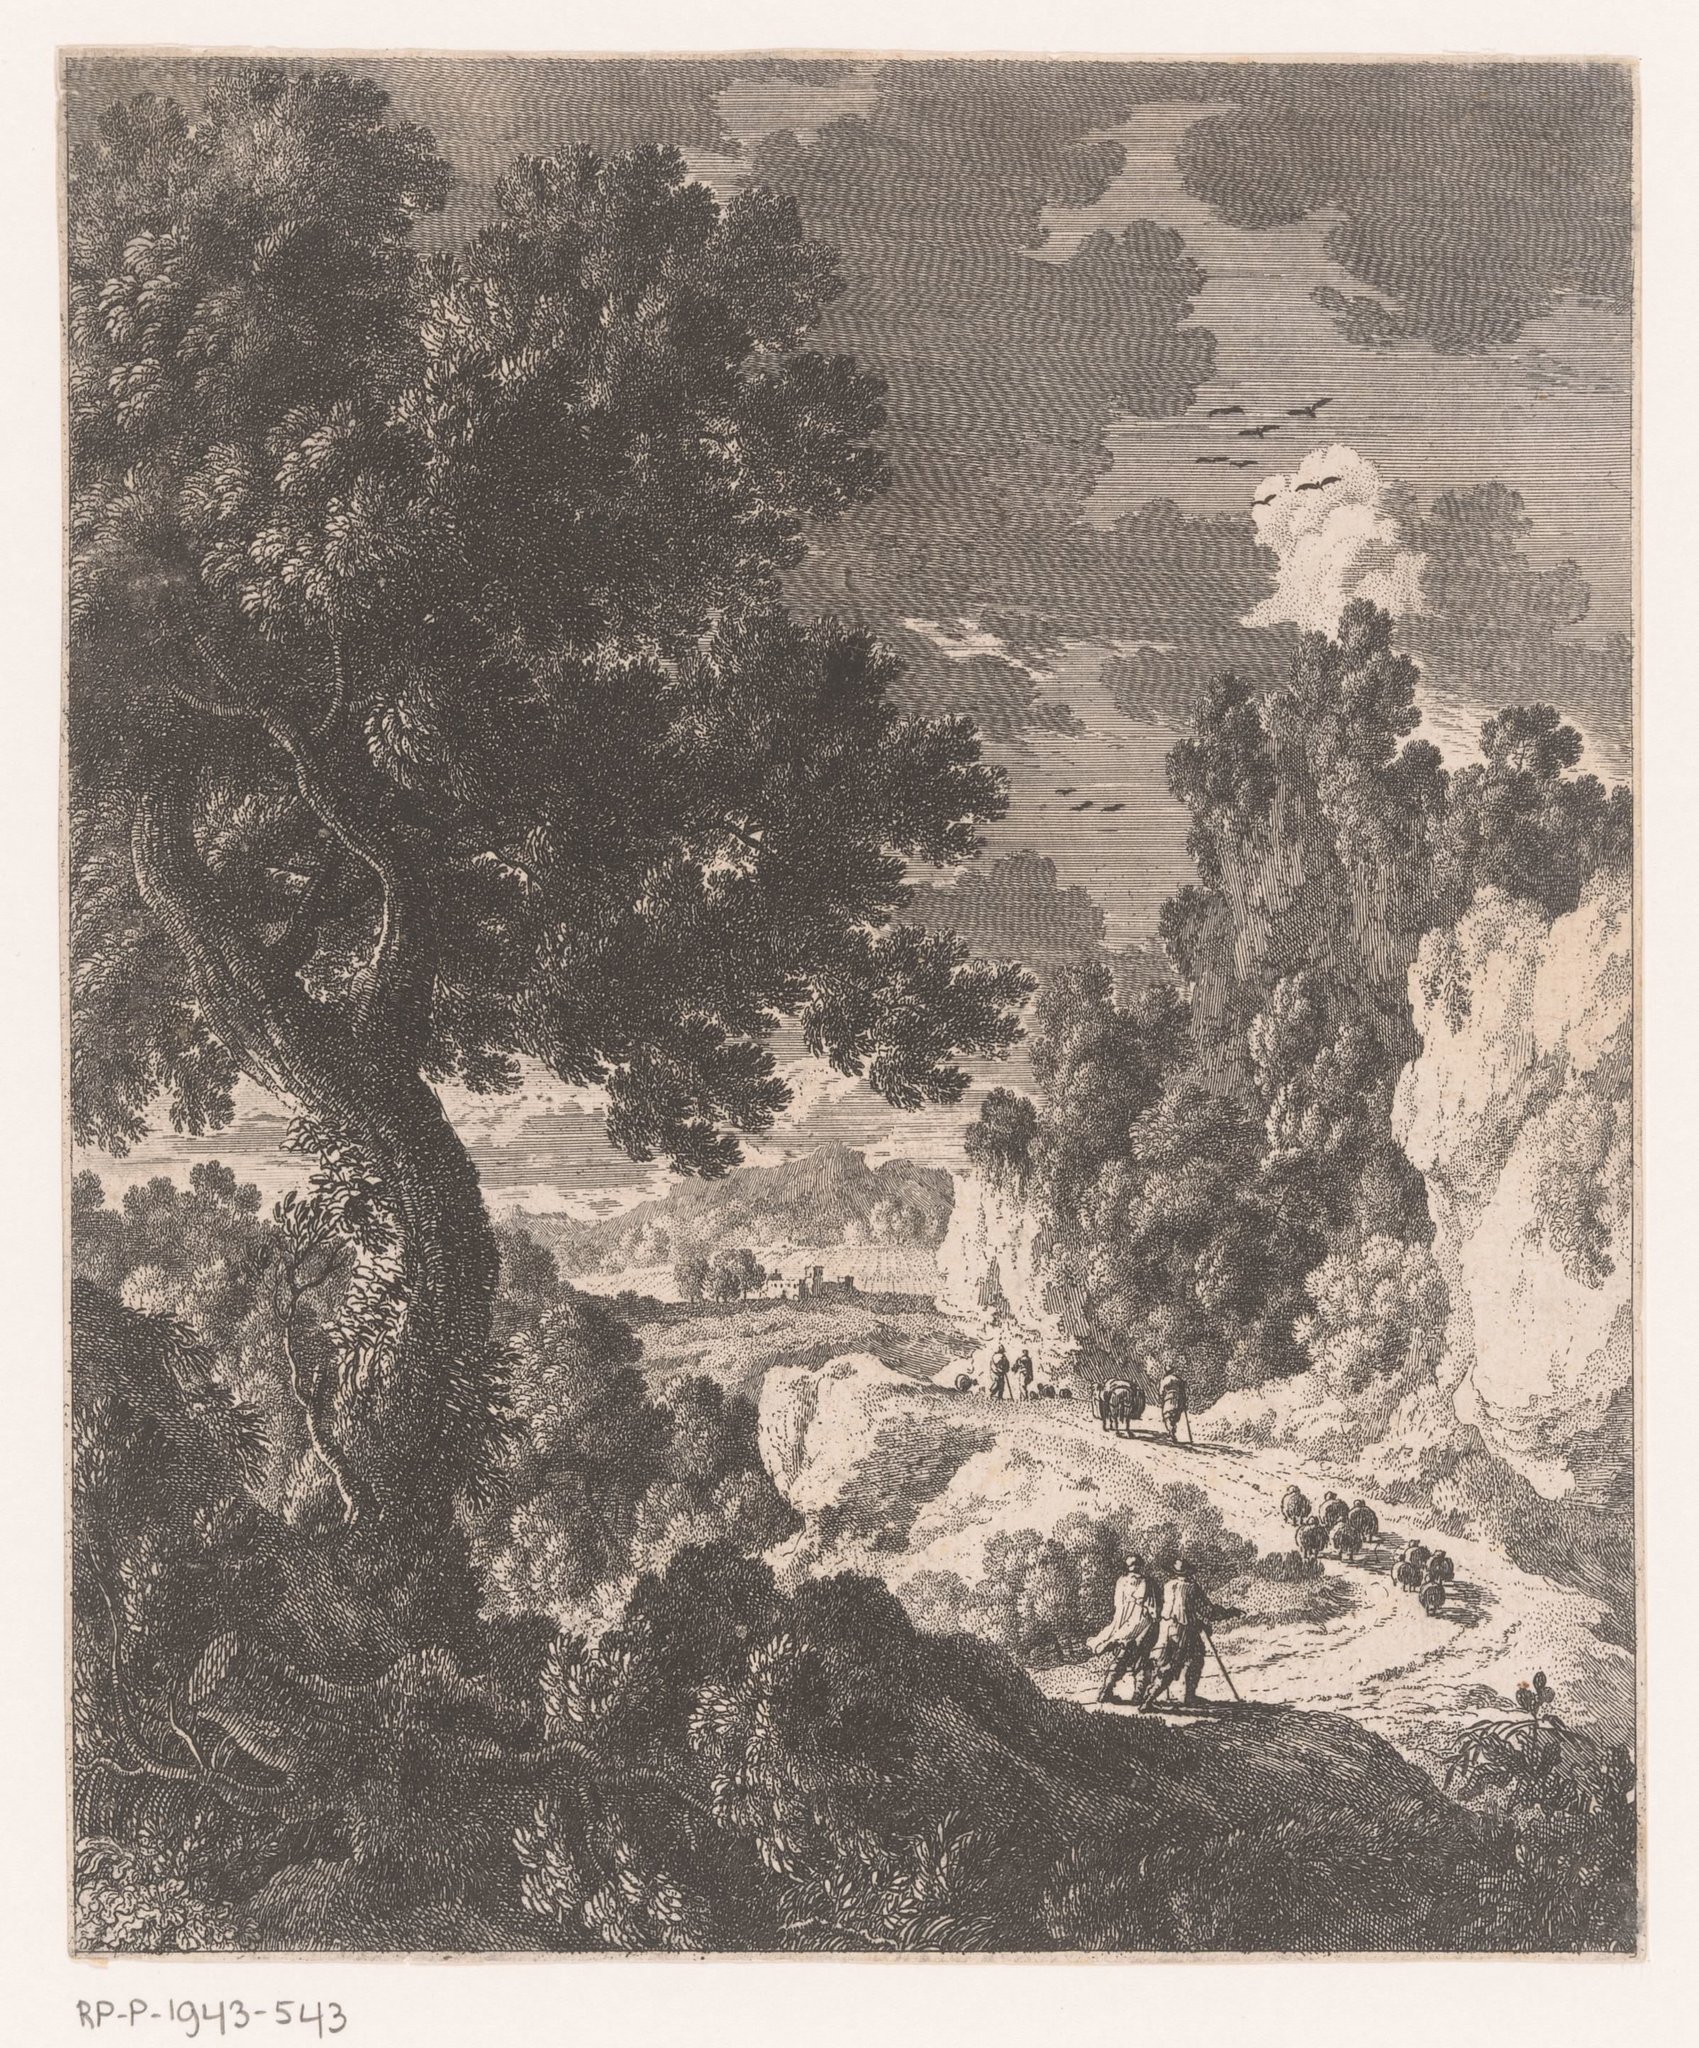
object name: print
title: Berglandschap met herders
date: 1613-1695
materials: paper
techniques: engraving, etching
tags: herding, herdsman, herdswoman, shepherd, shepherdess, cowherd, etc., pastorals, arcadian scenes, mountains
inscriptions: collector's mark: Lugt 2228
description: Prenten met het signatuur 'Perelle' kunnen zowel door vader Gabriel als door zonen Nicolas en Adam gemaakt zijn.